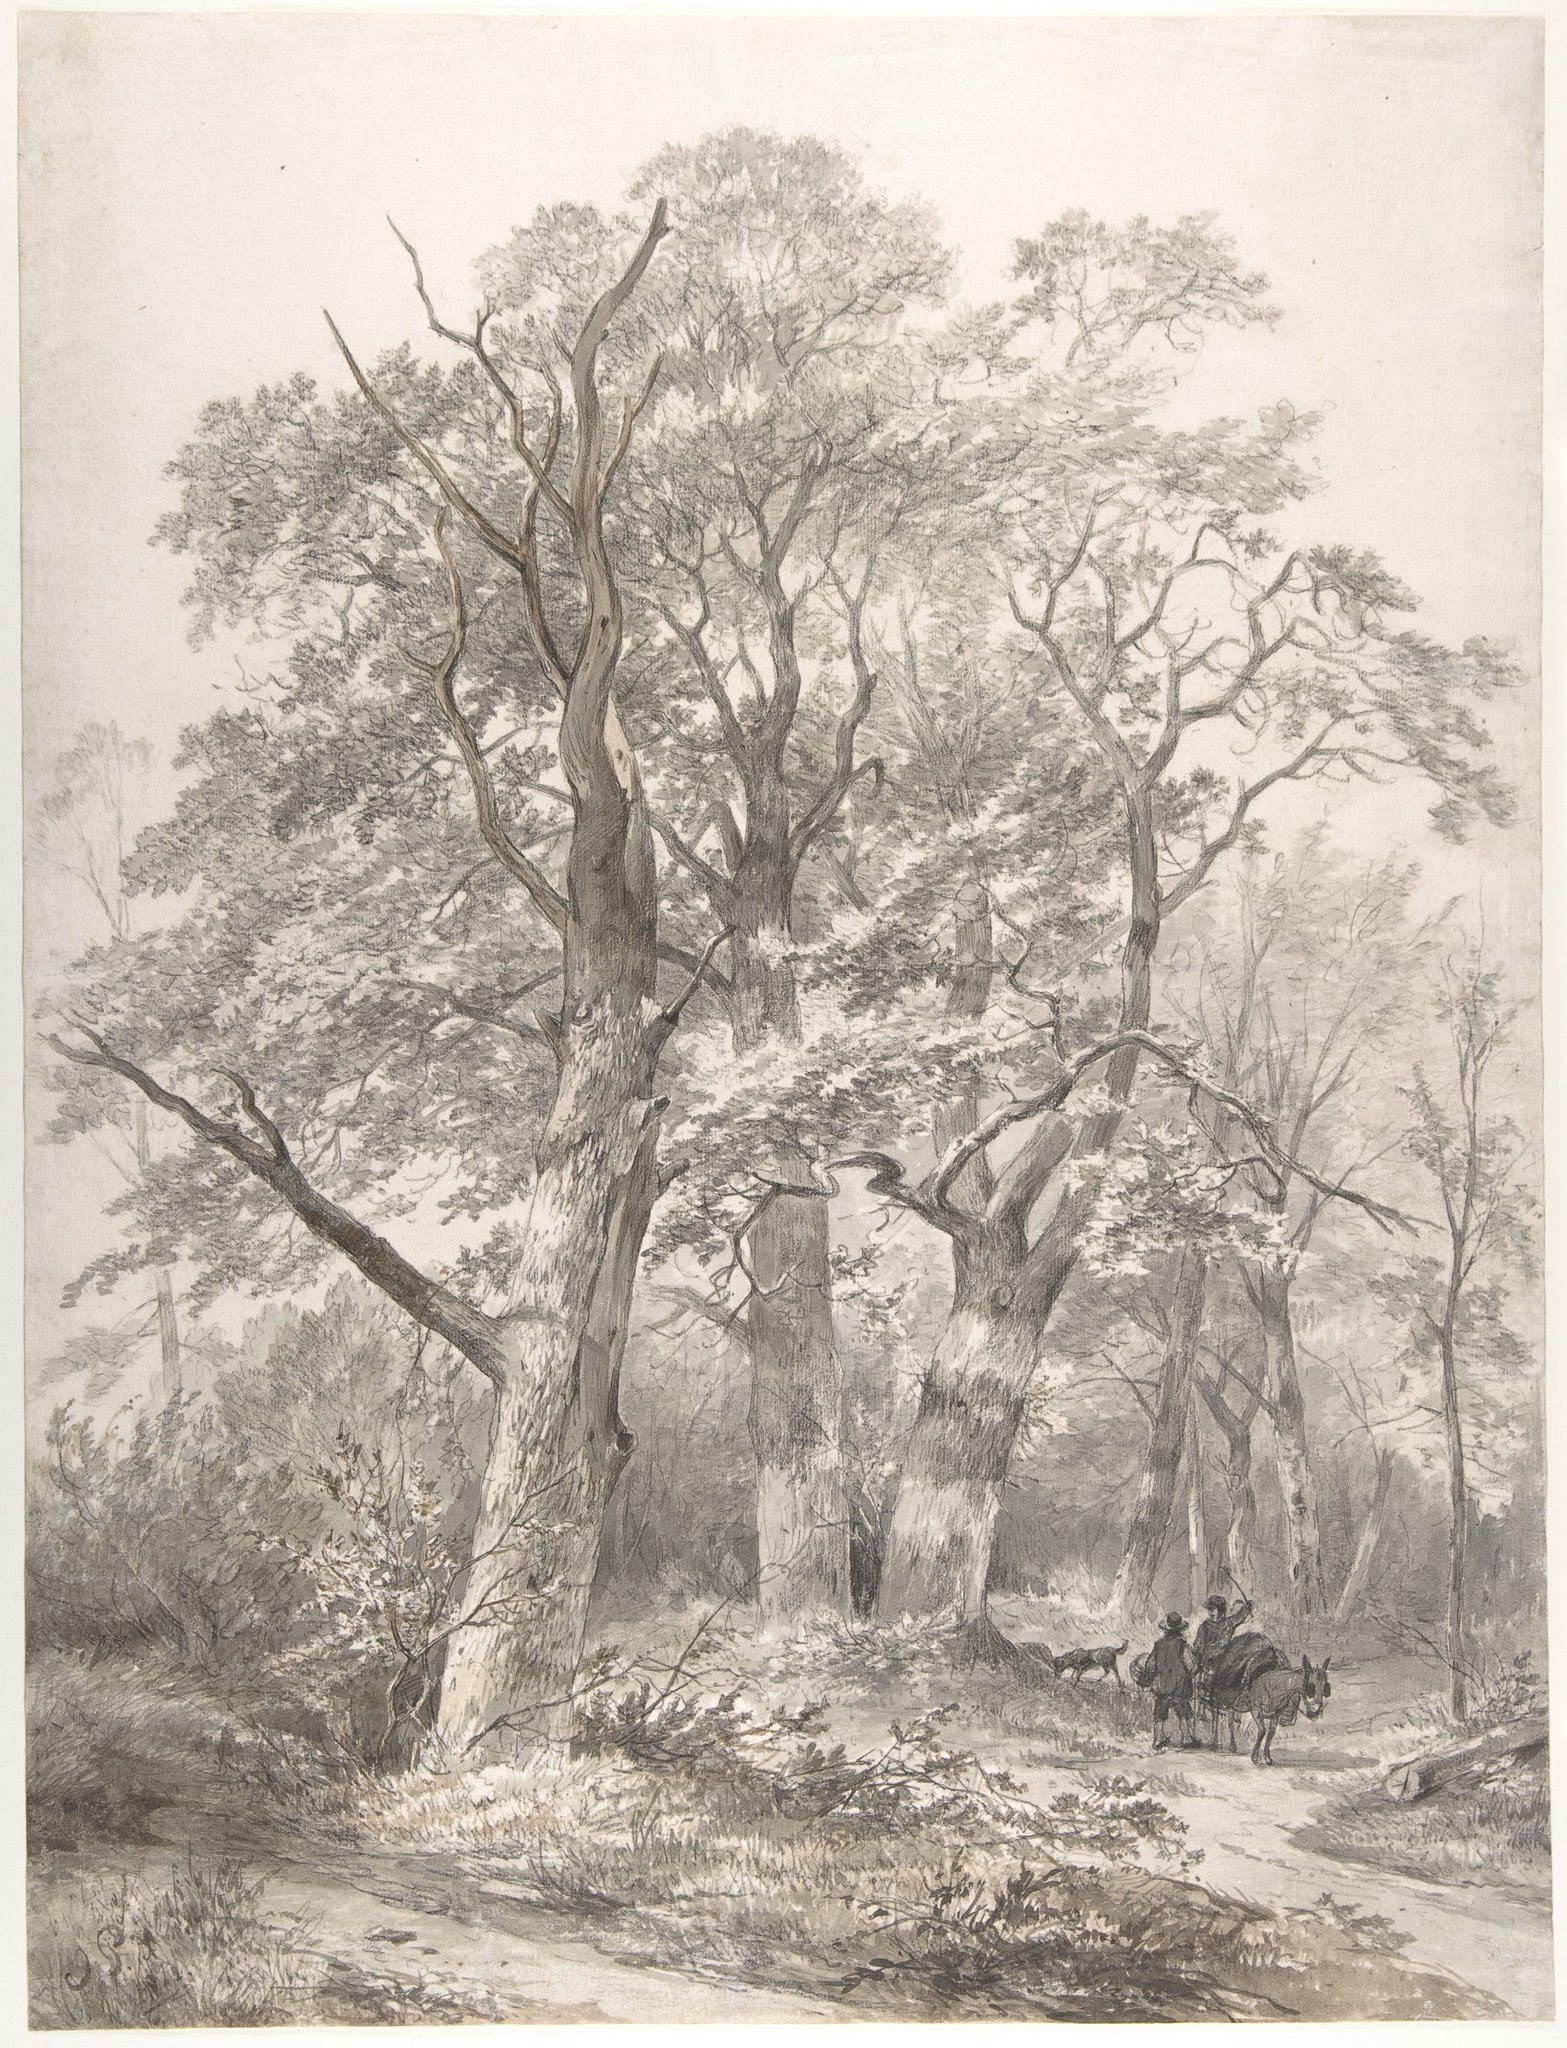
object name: drawing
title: A Forest with Two Men Conversing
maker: jacobus pelgrom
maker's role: draughtsman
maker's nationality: dutch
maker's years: 1811-1861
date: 1842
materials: chalk, ink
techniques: brush, pen, wash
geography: netherlands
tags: men,dogs,donkeys,forests,trees